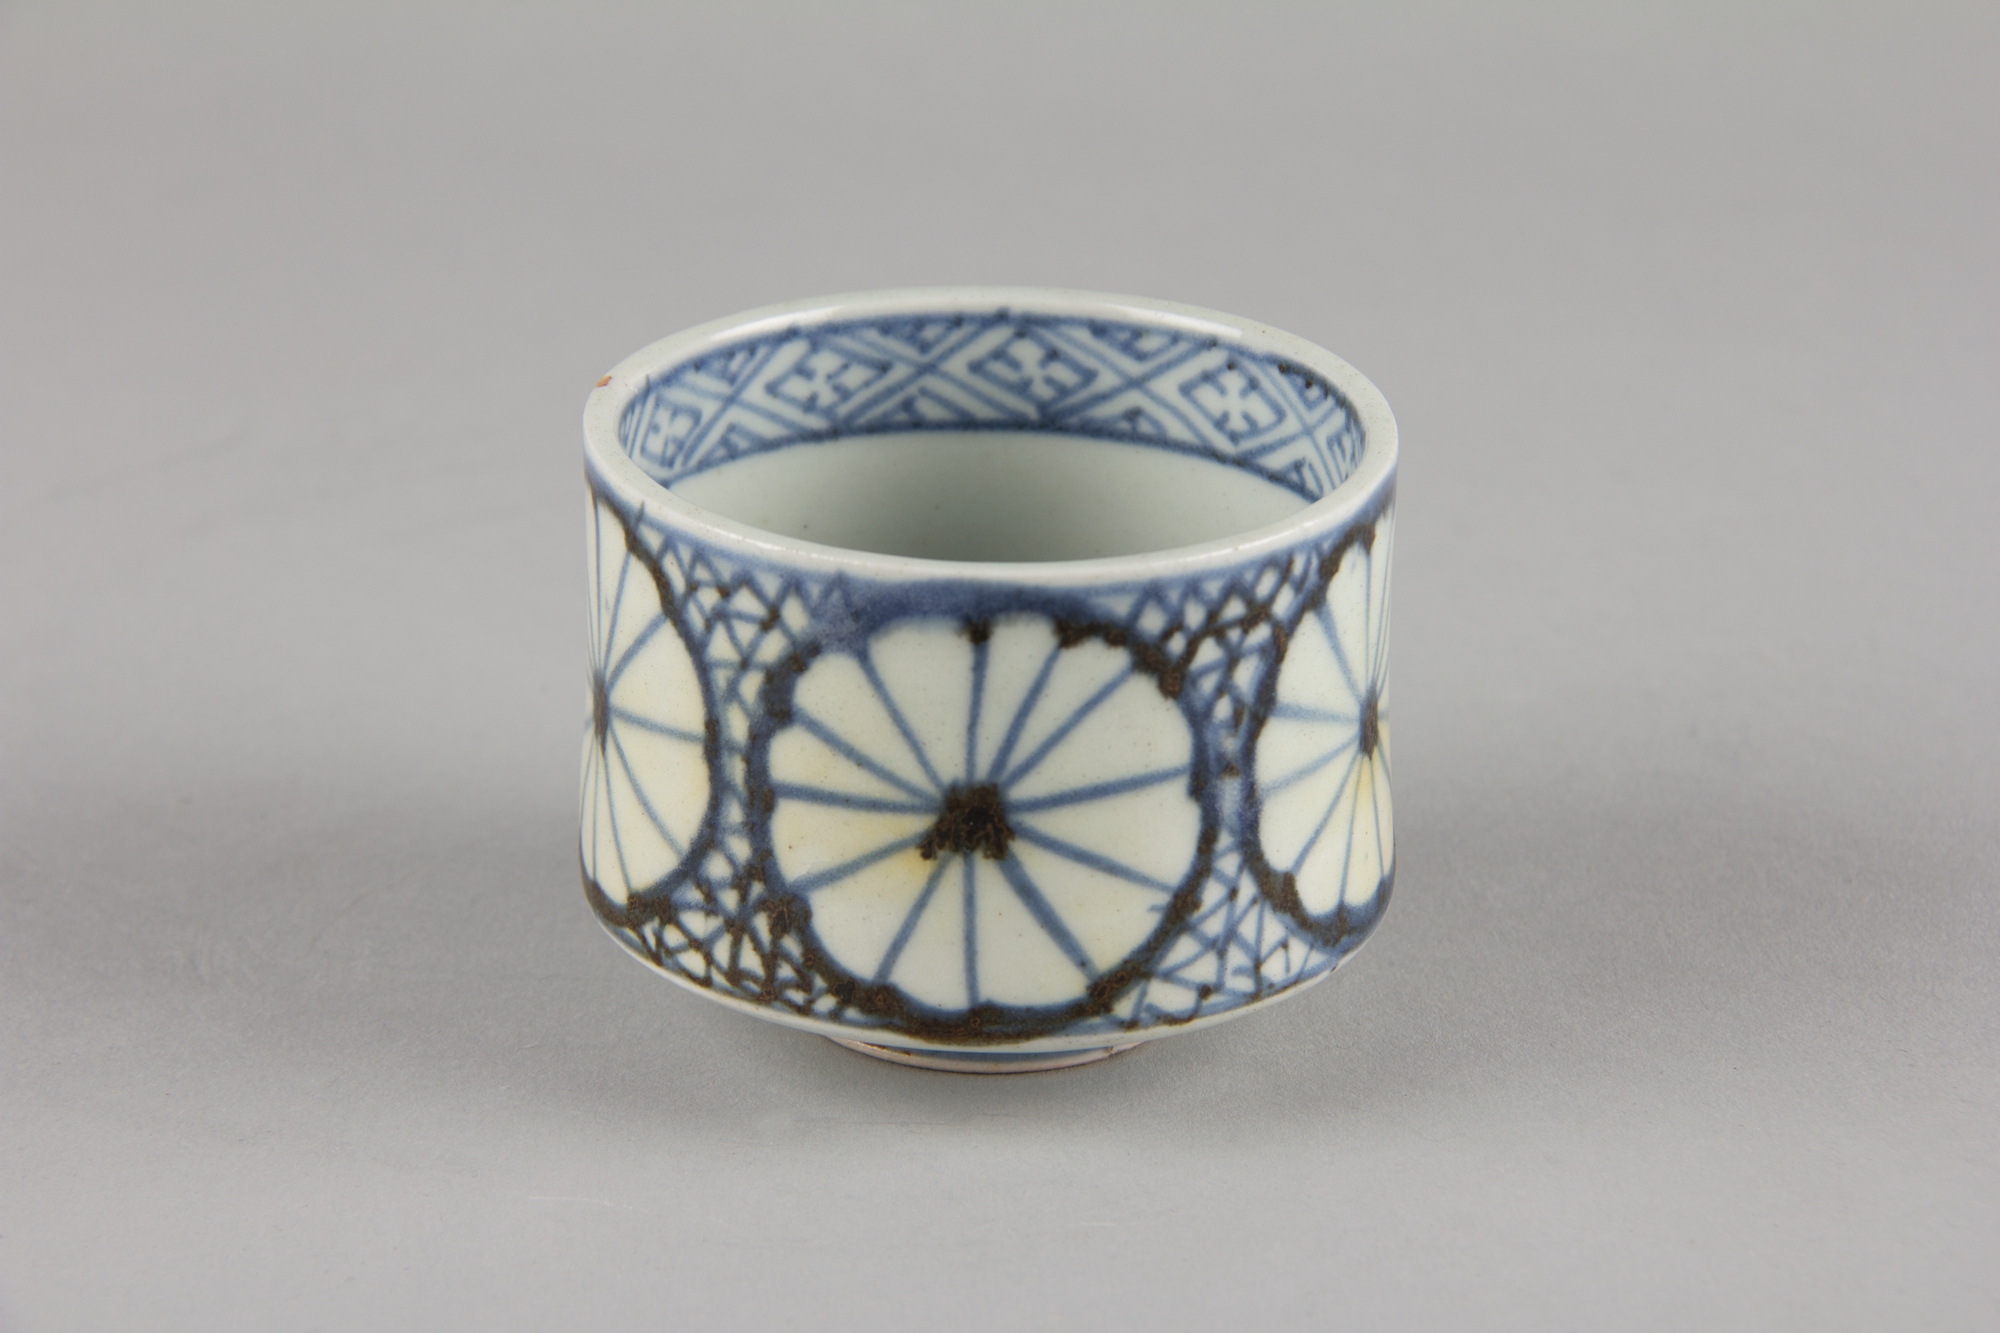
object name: soba cup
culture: japanese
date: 1801-1900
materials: cobalt, porcelain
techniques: painting, underglaze